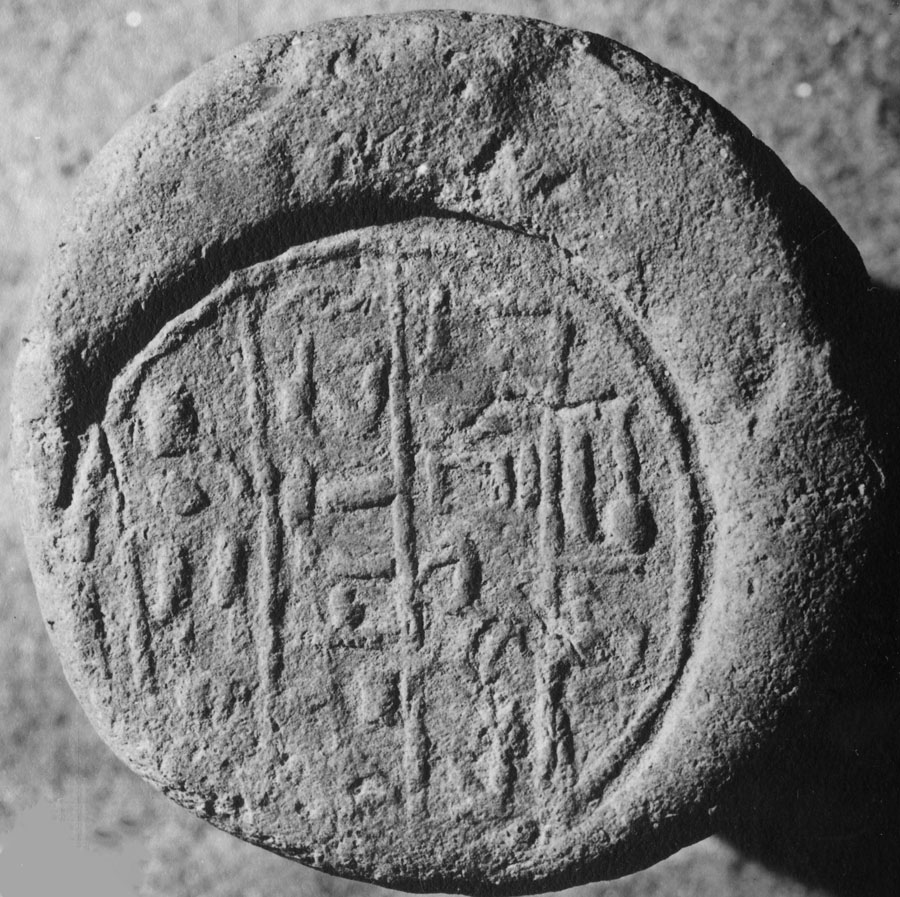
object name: cone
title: Funerary Cone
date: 1550-1295 BCE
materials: pottery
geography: egypt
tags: hieroglyphs